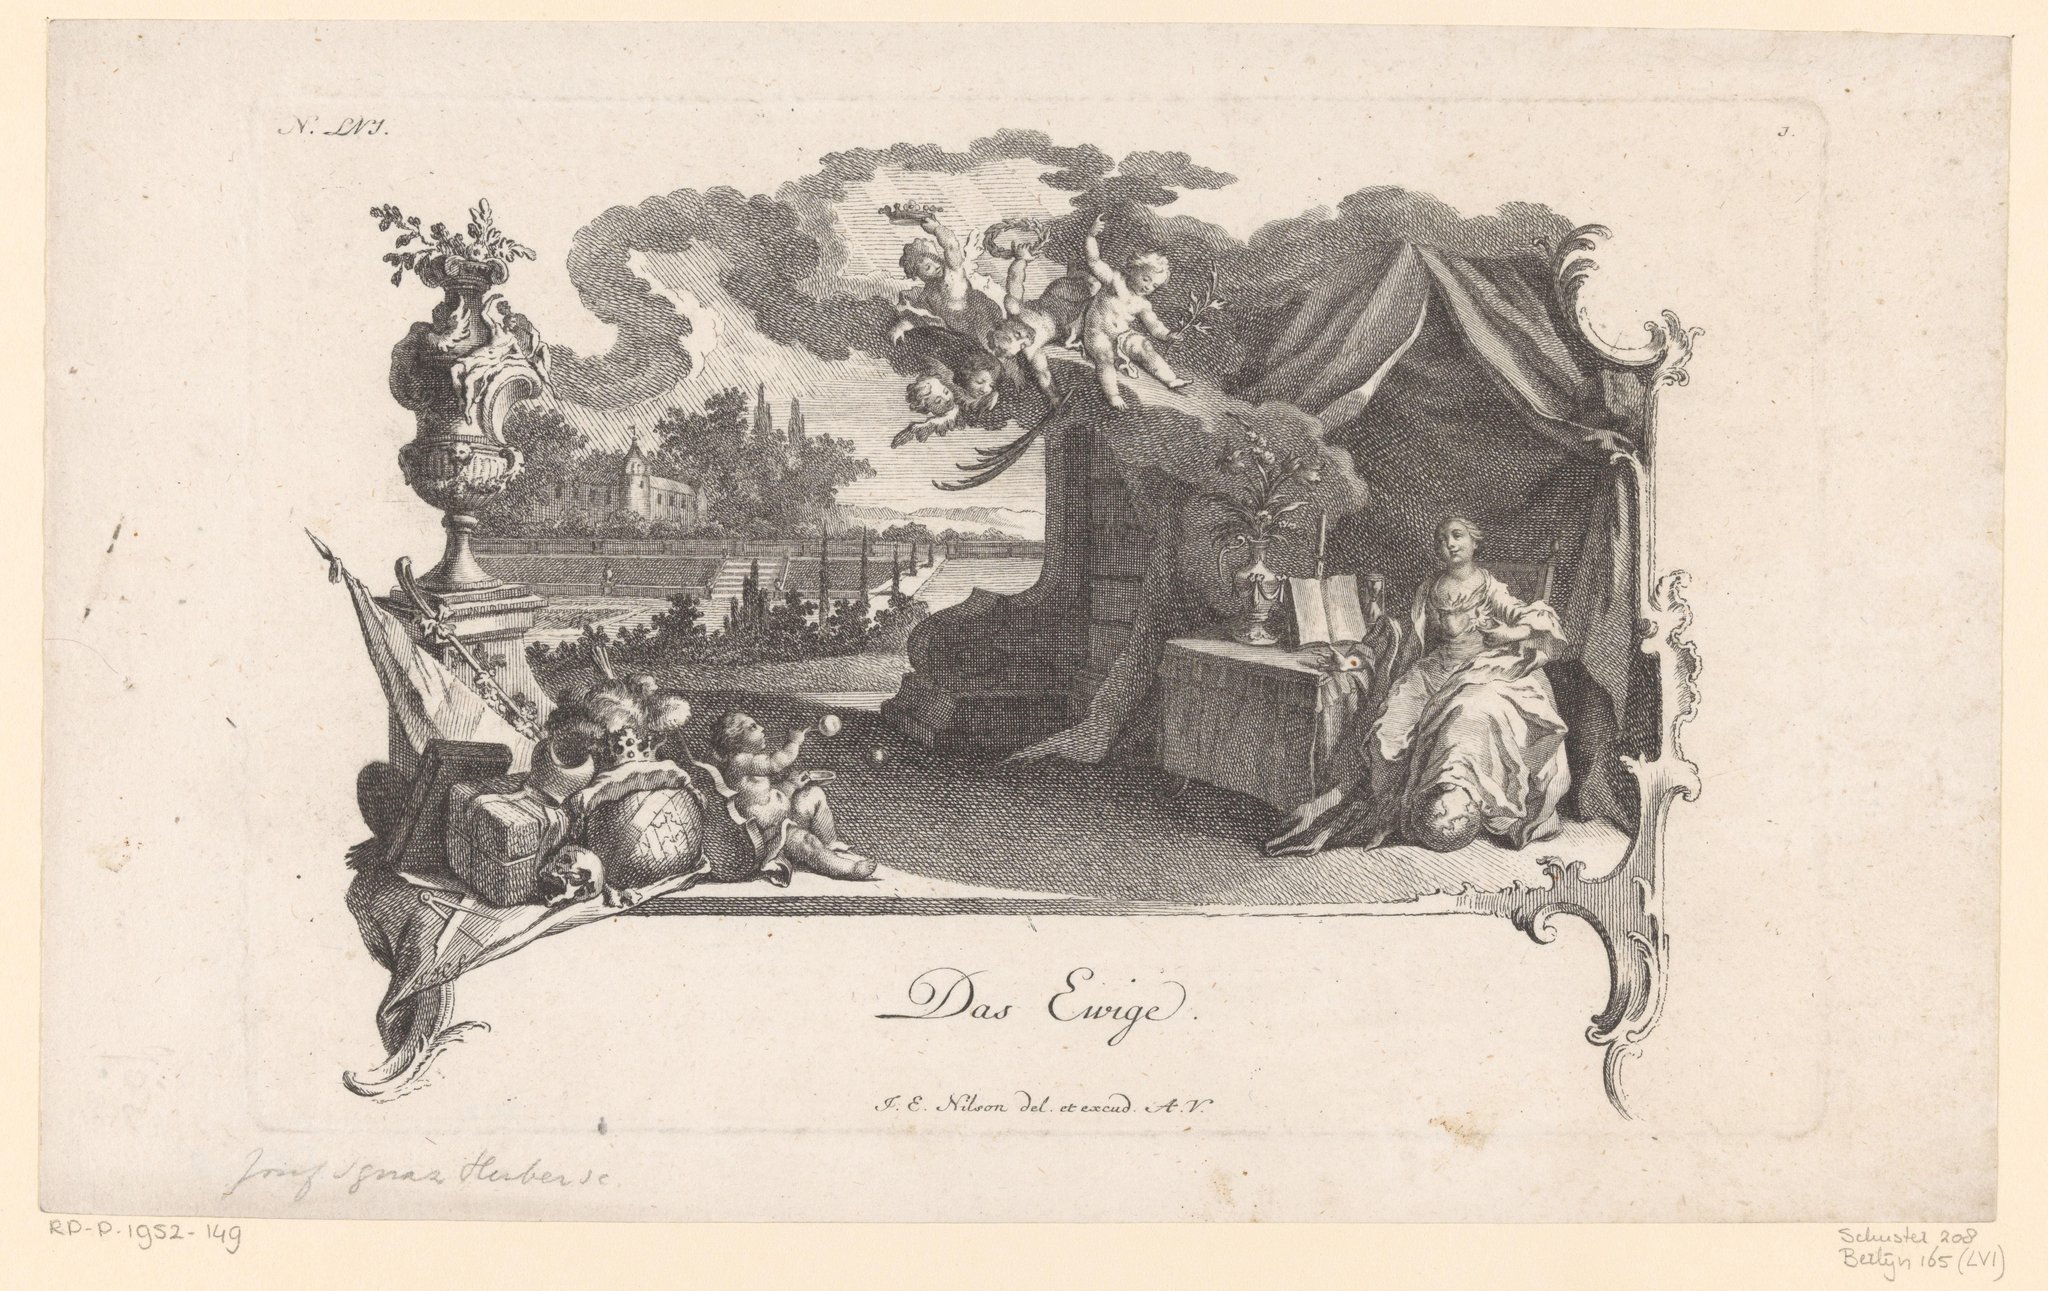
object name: ornament print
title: Das Ewige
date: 1769-1788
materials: paper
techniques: engraving, etching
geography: augsburg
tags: sitting figure - aa - female human figure, eternity, 'aeternitas'; 'eternità','eternità o perpetuità' (ripa), the life of man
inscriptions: collector's mark: Lugt 2228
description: Allegorische voorstelling van het eeuwige. Rechts aan tafel onder een baldakijn zit een vrouw met een brandend hart en een globe aan haar voeten. Putti op met een kroon, een lauwerkrans en een palmtak zitten op wolken en begroeten haar. Links, naast een voetstuk met een vaas, is een putto aan het bellenblazen. Hij zit naast objecten die het aardse leven symboliseren. Uitgeversnummer LVI.